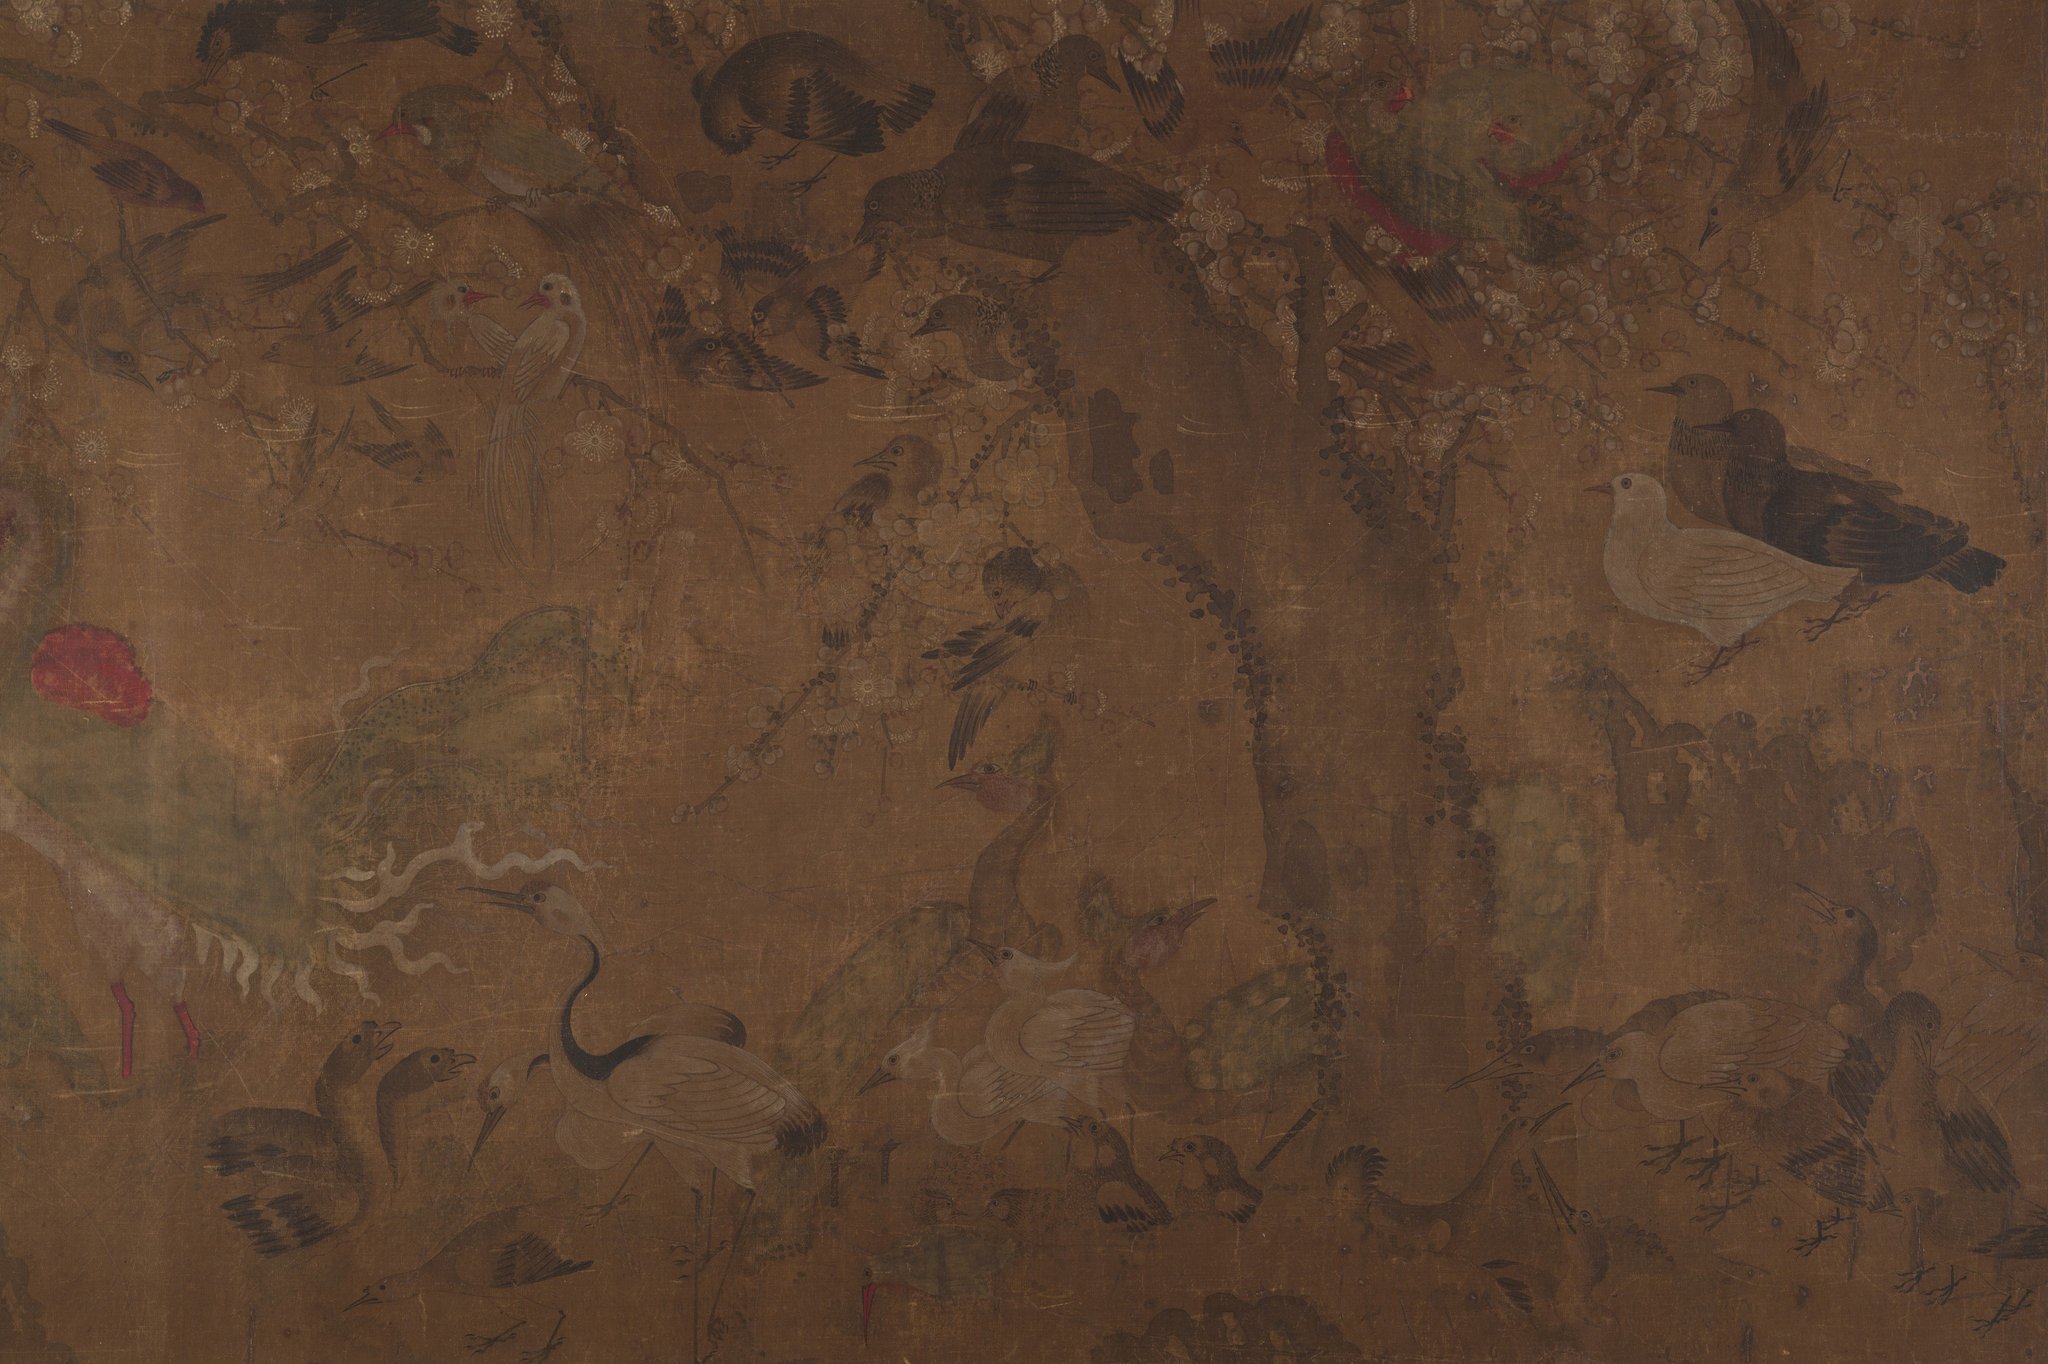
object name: handscroll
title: The Hundred Birds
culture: chinese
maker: unidentified artist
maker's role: artist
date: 1368-1644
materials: silk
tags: birds